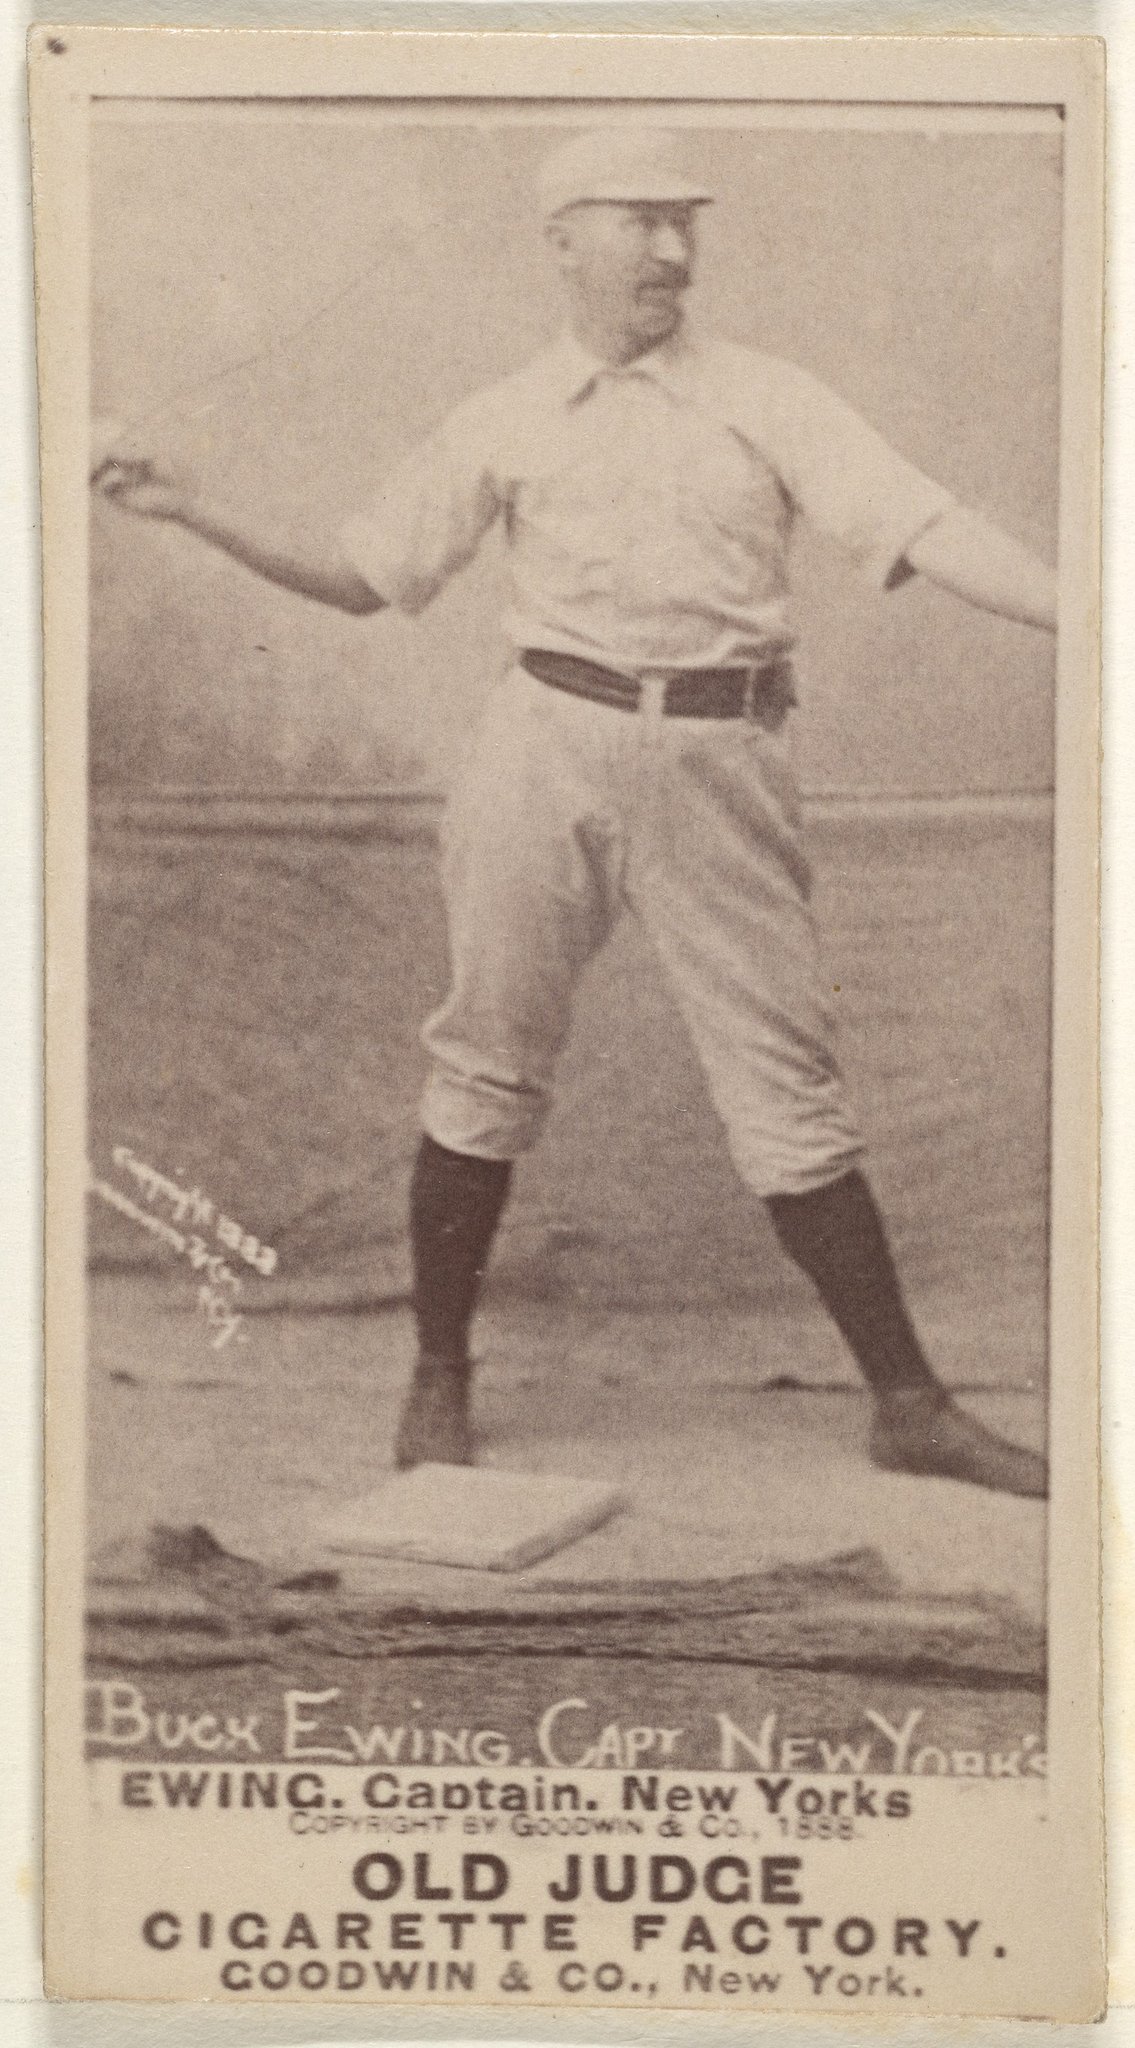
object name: baseball card, photograph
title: William "Buck" Ewing, Captain and Catcher, New York, from the Old Judge series (N172) for Old Judge Cigarettes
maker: goodwin & company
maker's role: publisher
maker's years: 1850-1950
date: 1888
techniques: albumen silver print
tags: men,portraits,baseball,athletes